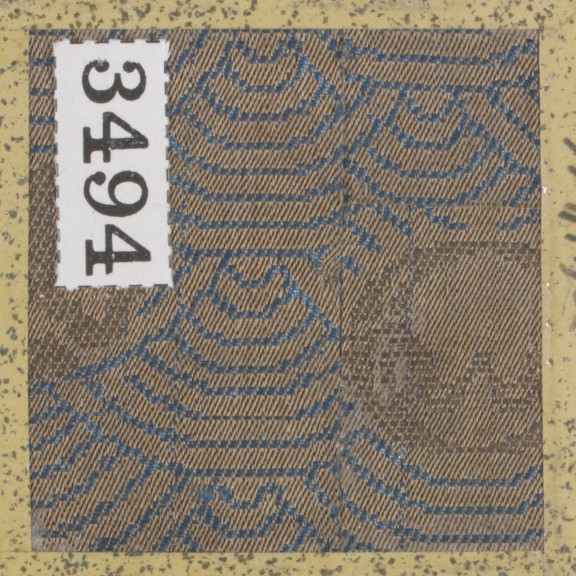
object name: sample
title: Textile Sample from Sample Book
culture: japanese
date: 1801-1900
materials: silk